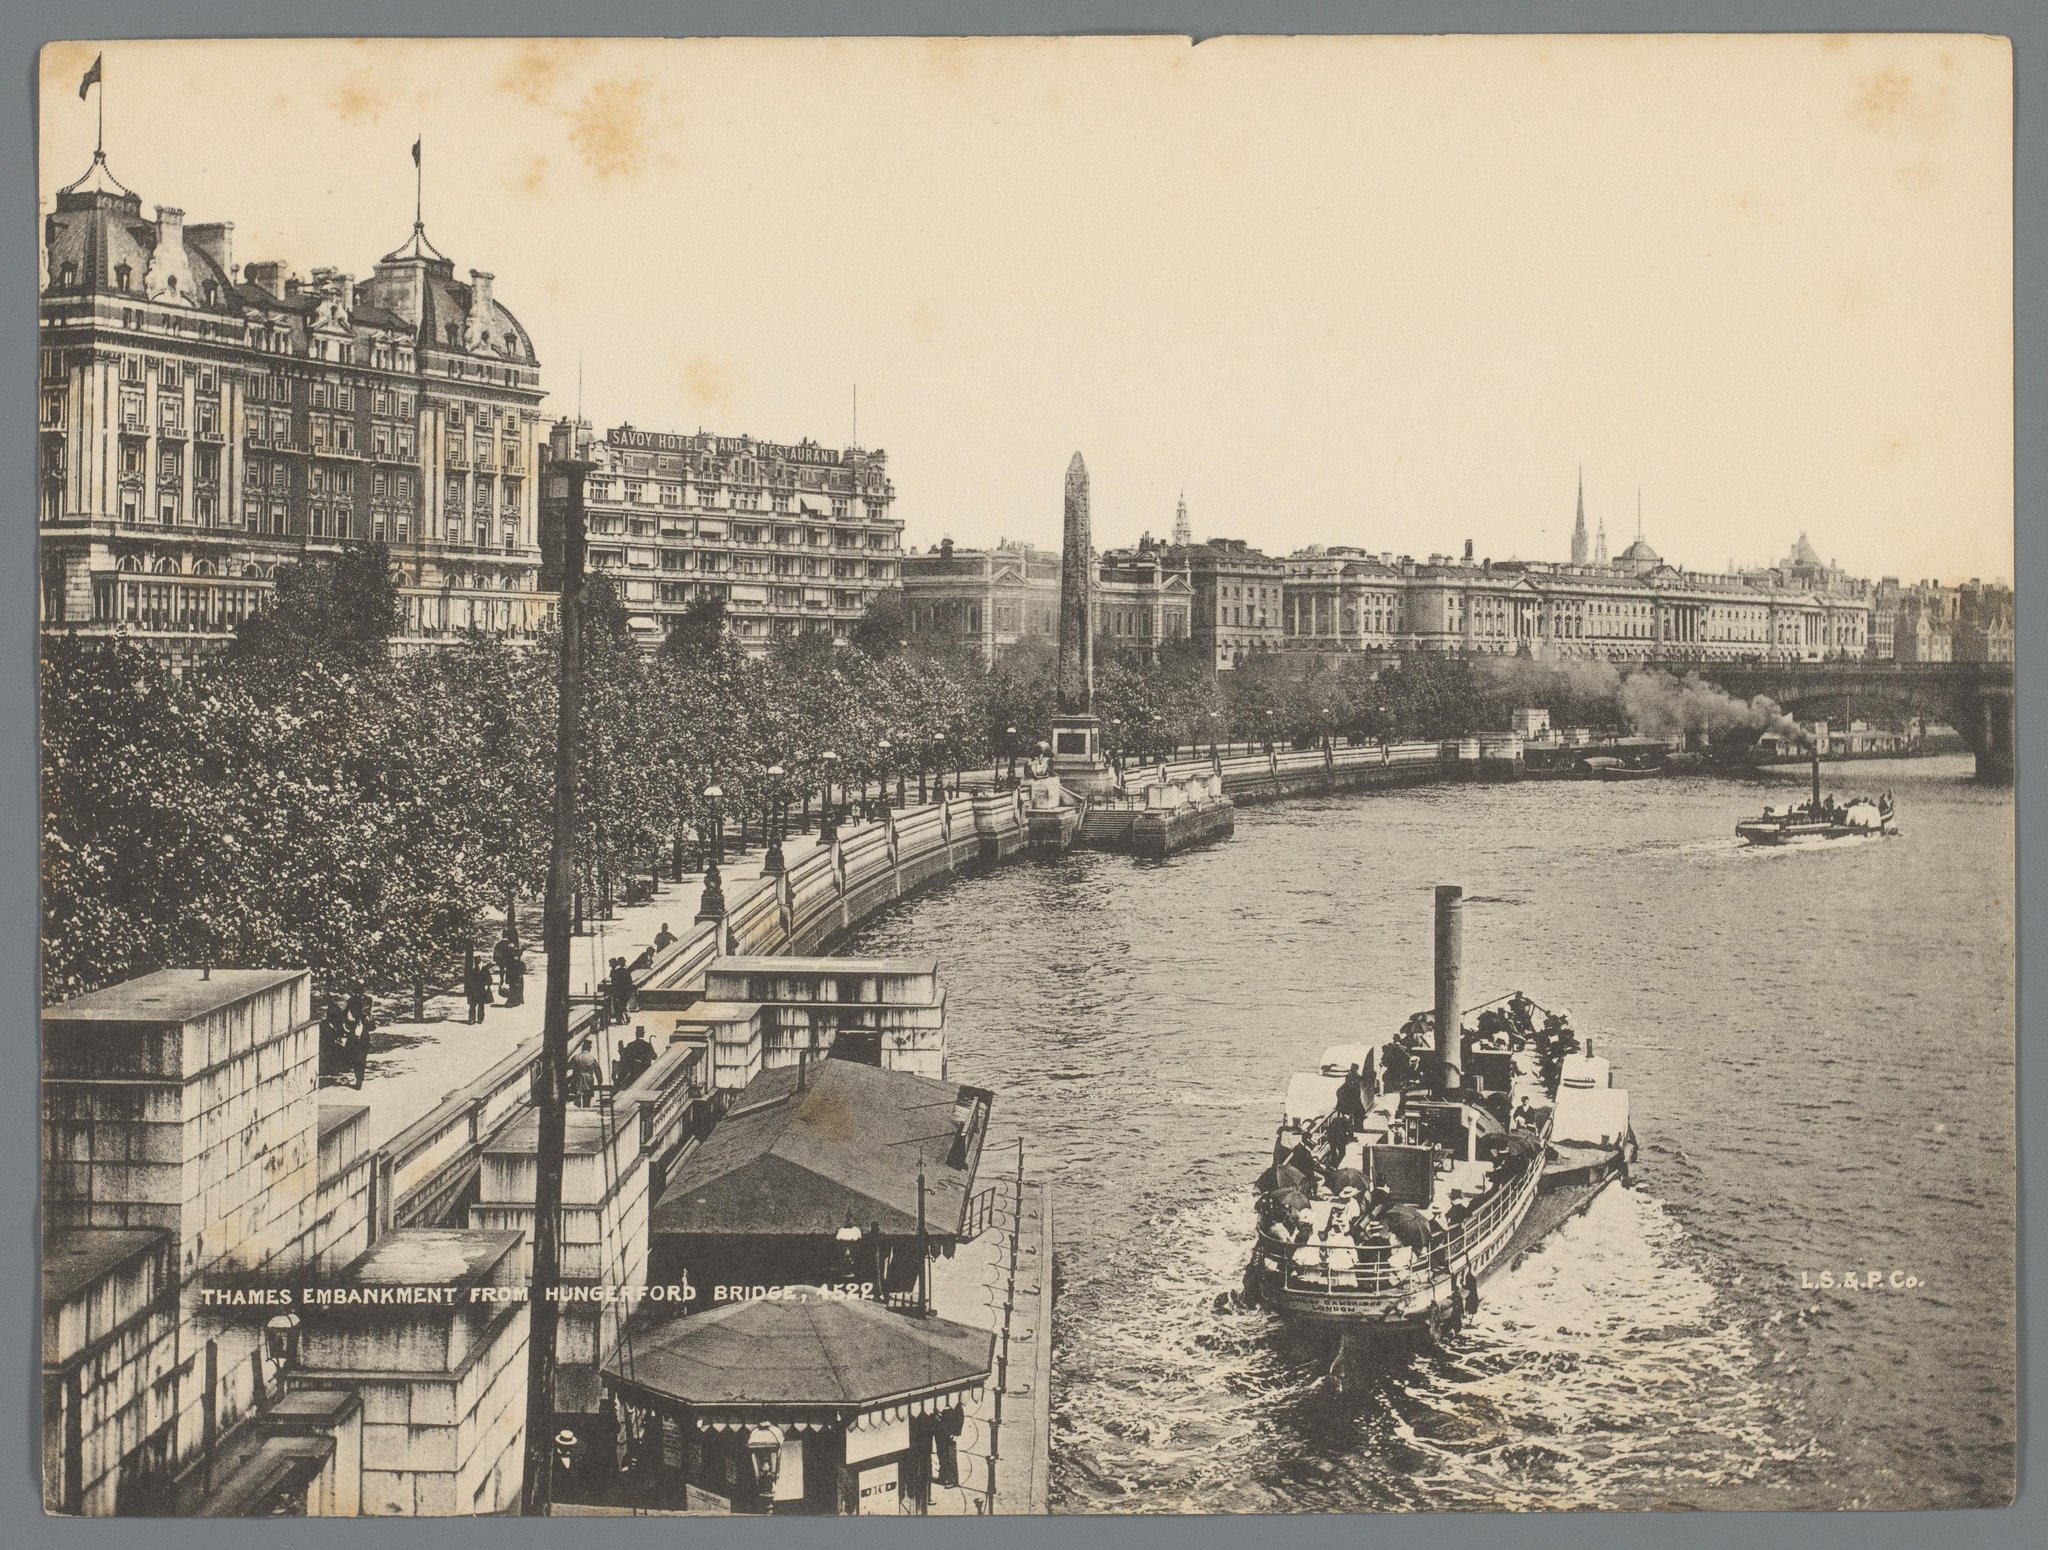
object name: photomechanical print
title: Thames Embankment from Hungerford Bridge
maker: Anonymous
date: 1870-1922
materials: paper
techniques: photograph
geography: london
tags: urban housing, river, quay, london, thames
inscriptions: number: ‘1522.’